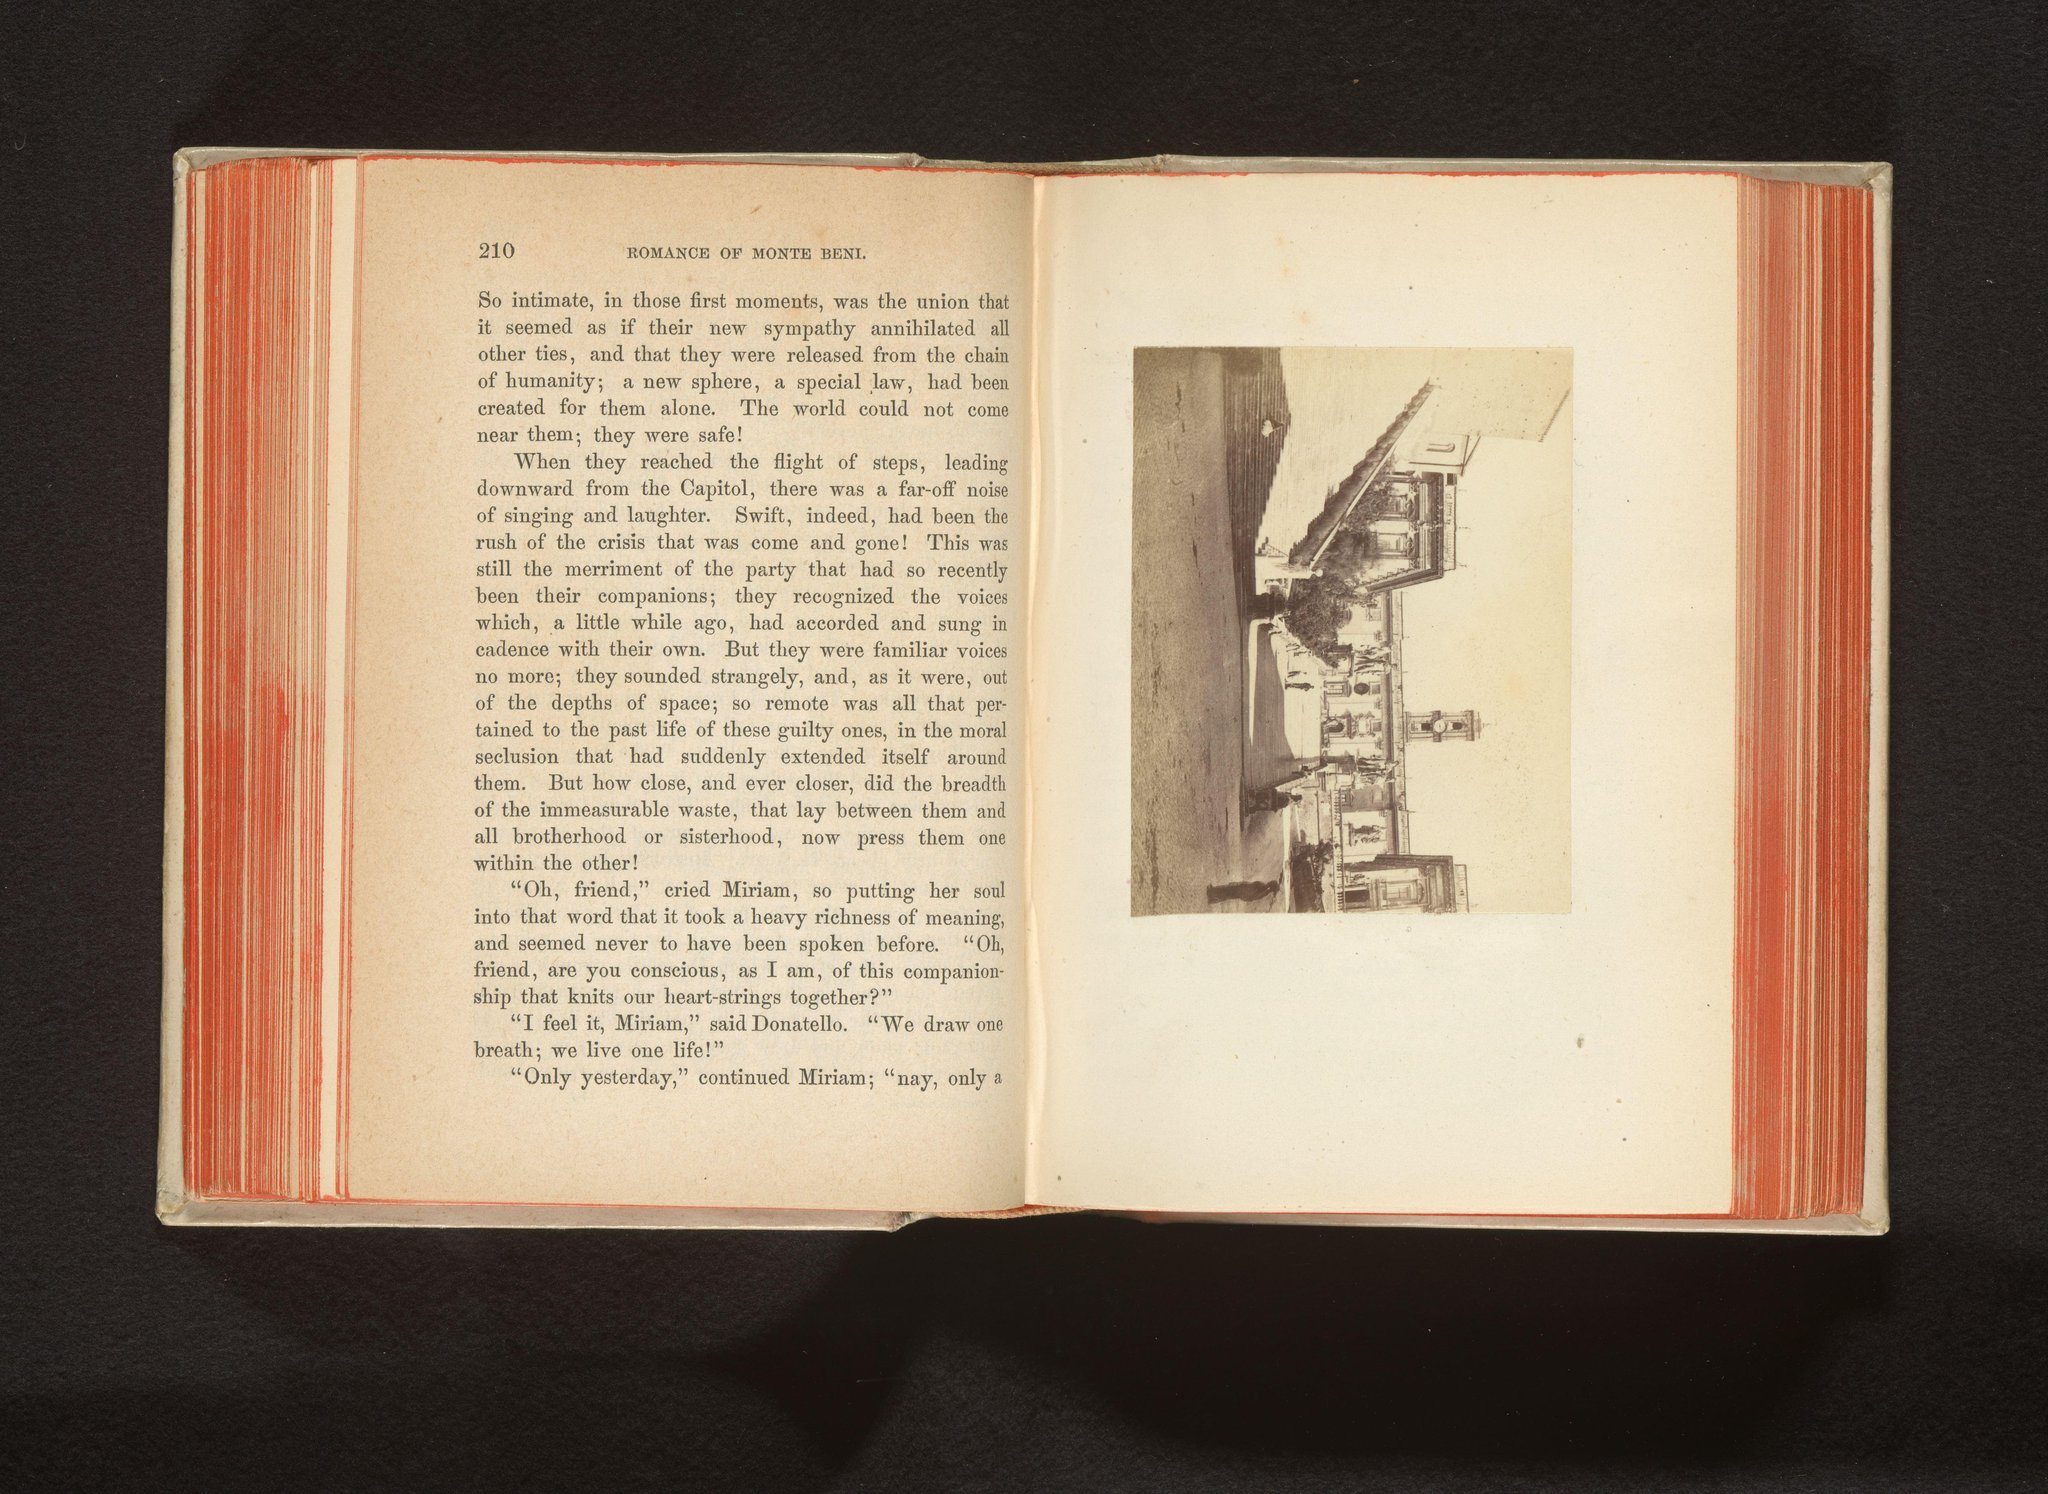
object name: page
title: Gezicht op de Cordonata naar het Senatorenpaleis en Piazza del Campidoglio in Rome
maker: Anonymous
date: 1850-1860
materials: photographic support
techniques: albumen print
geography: rome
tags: square, place, circus, etc., palace